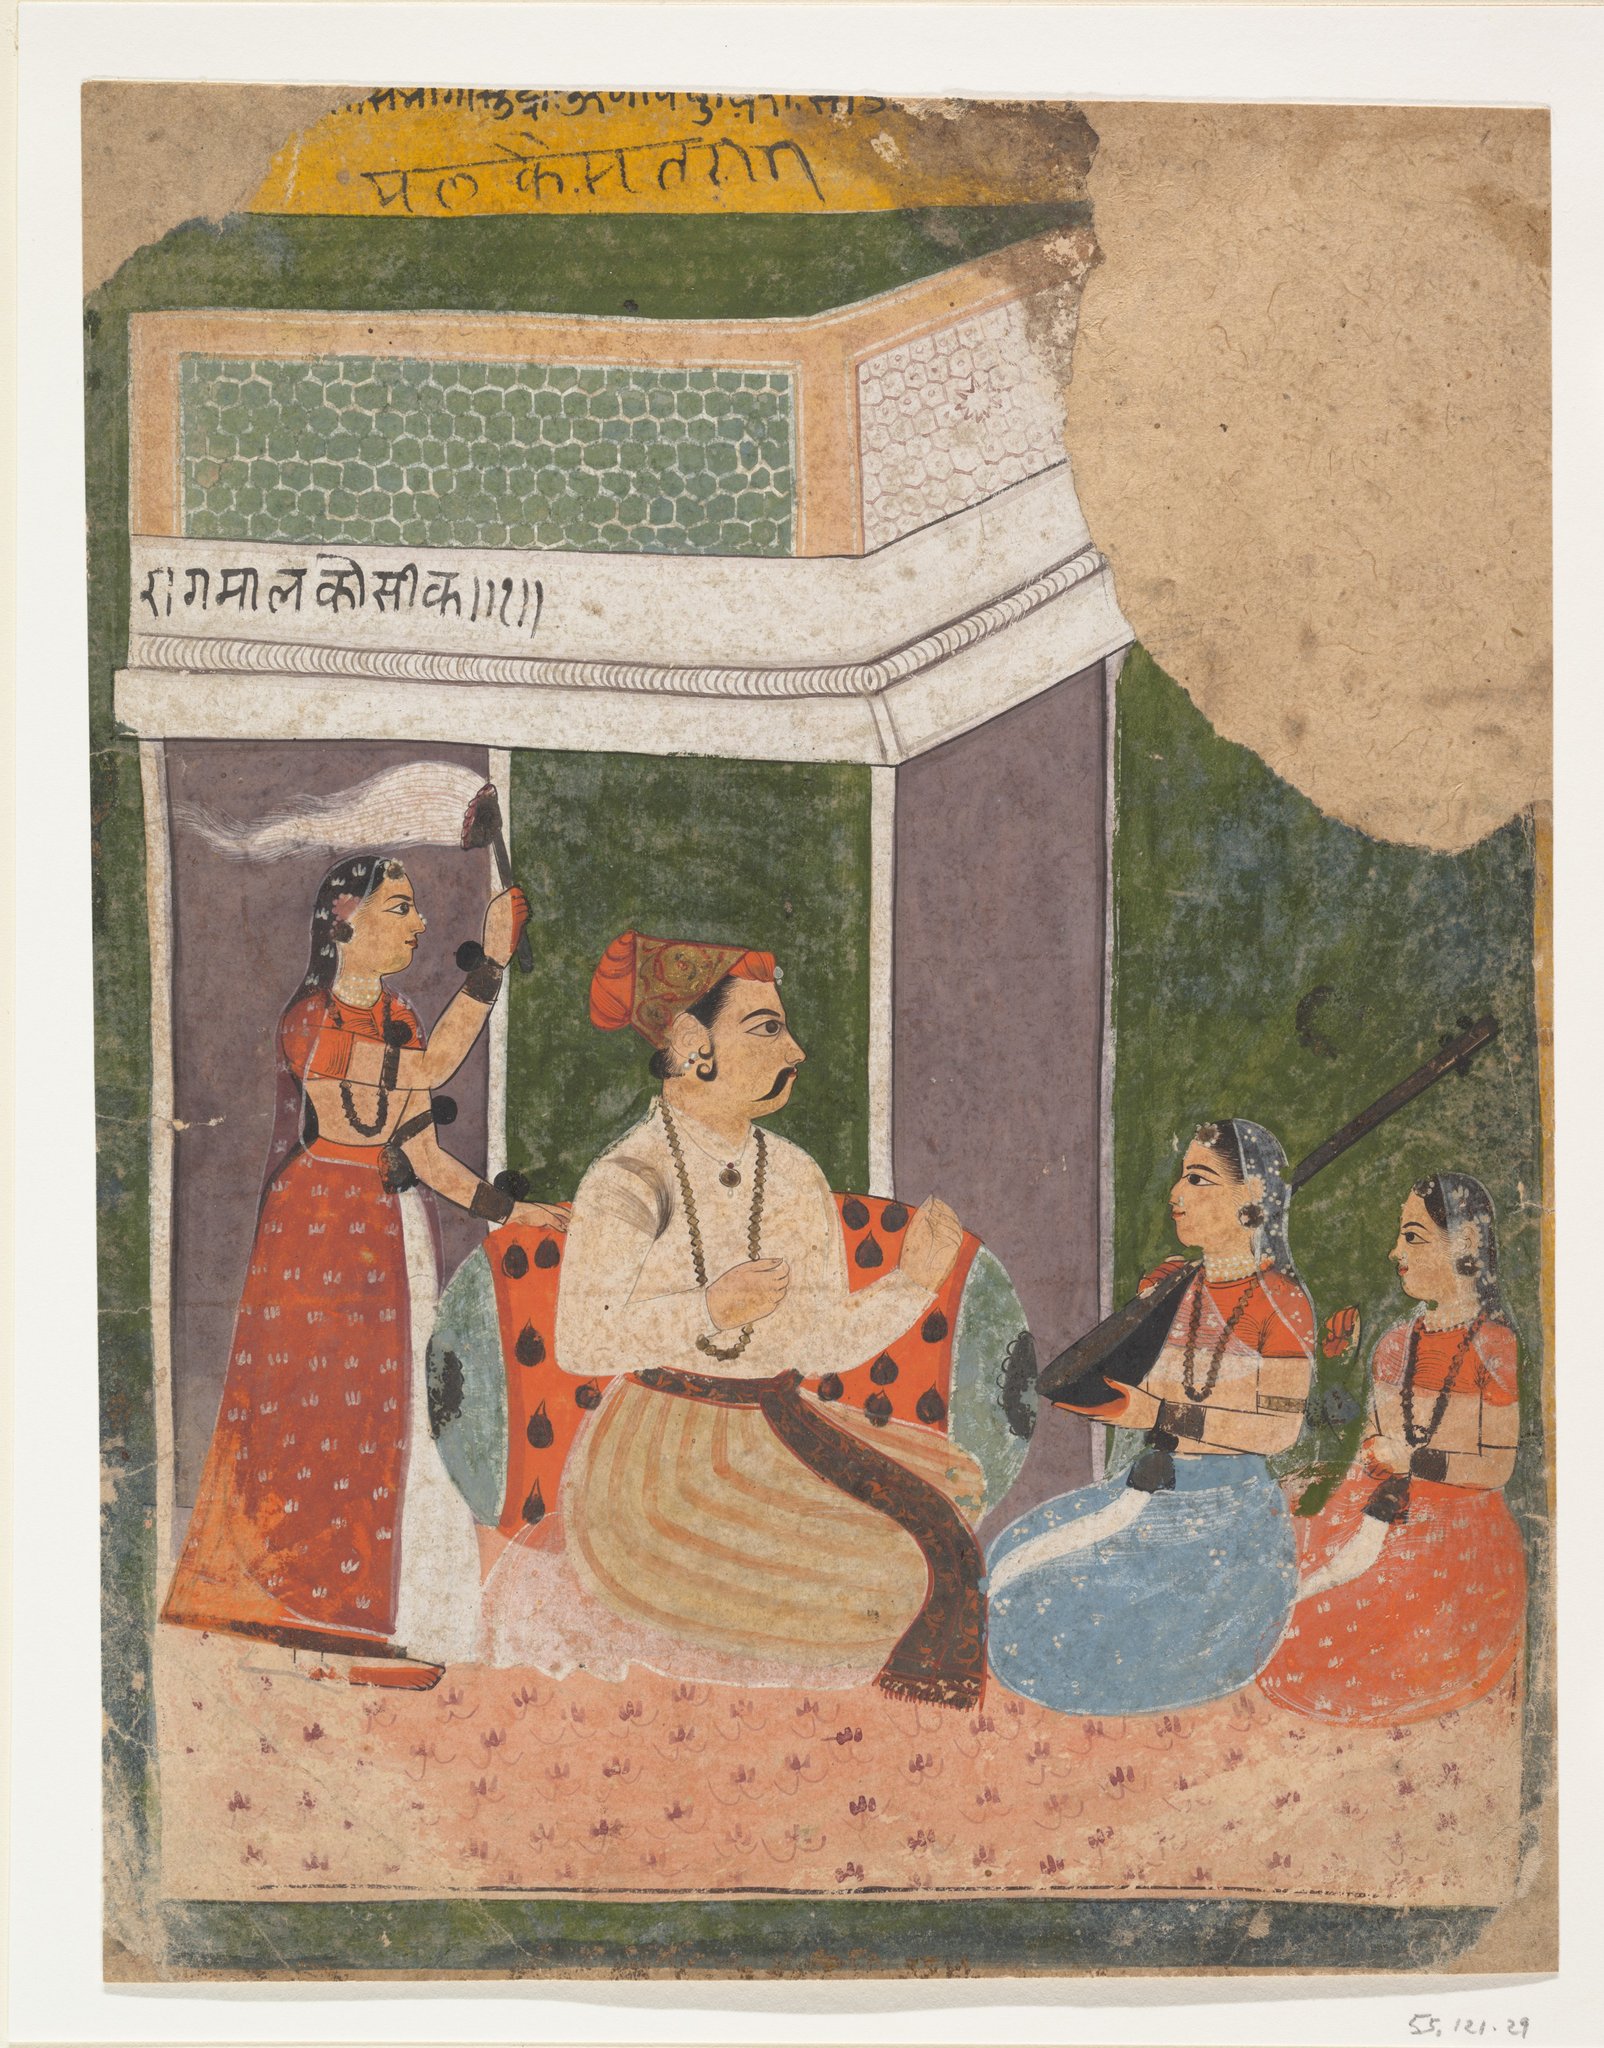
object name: folio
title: Malkos Raga: Page from a Dispersed Ragamala Series (Garland of Musical Modes)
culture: indian, rajasthan, marwar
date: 1640-1650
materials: ink, paper, watercolor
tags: musical instruments,men,women